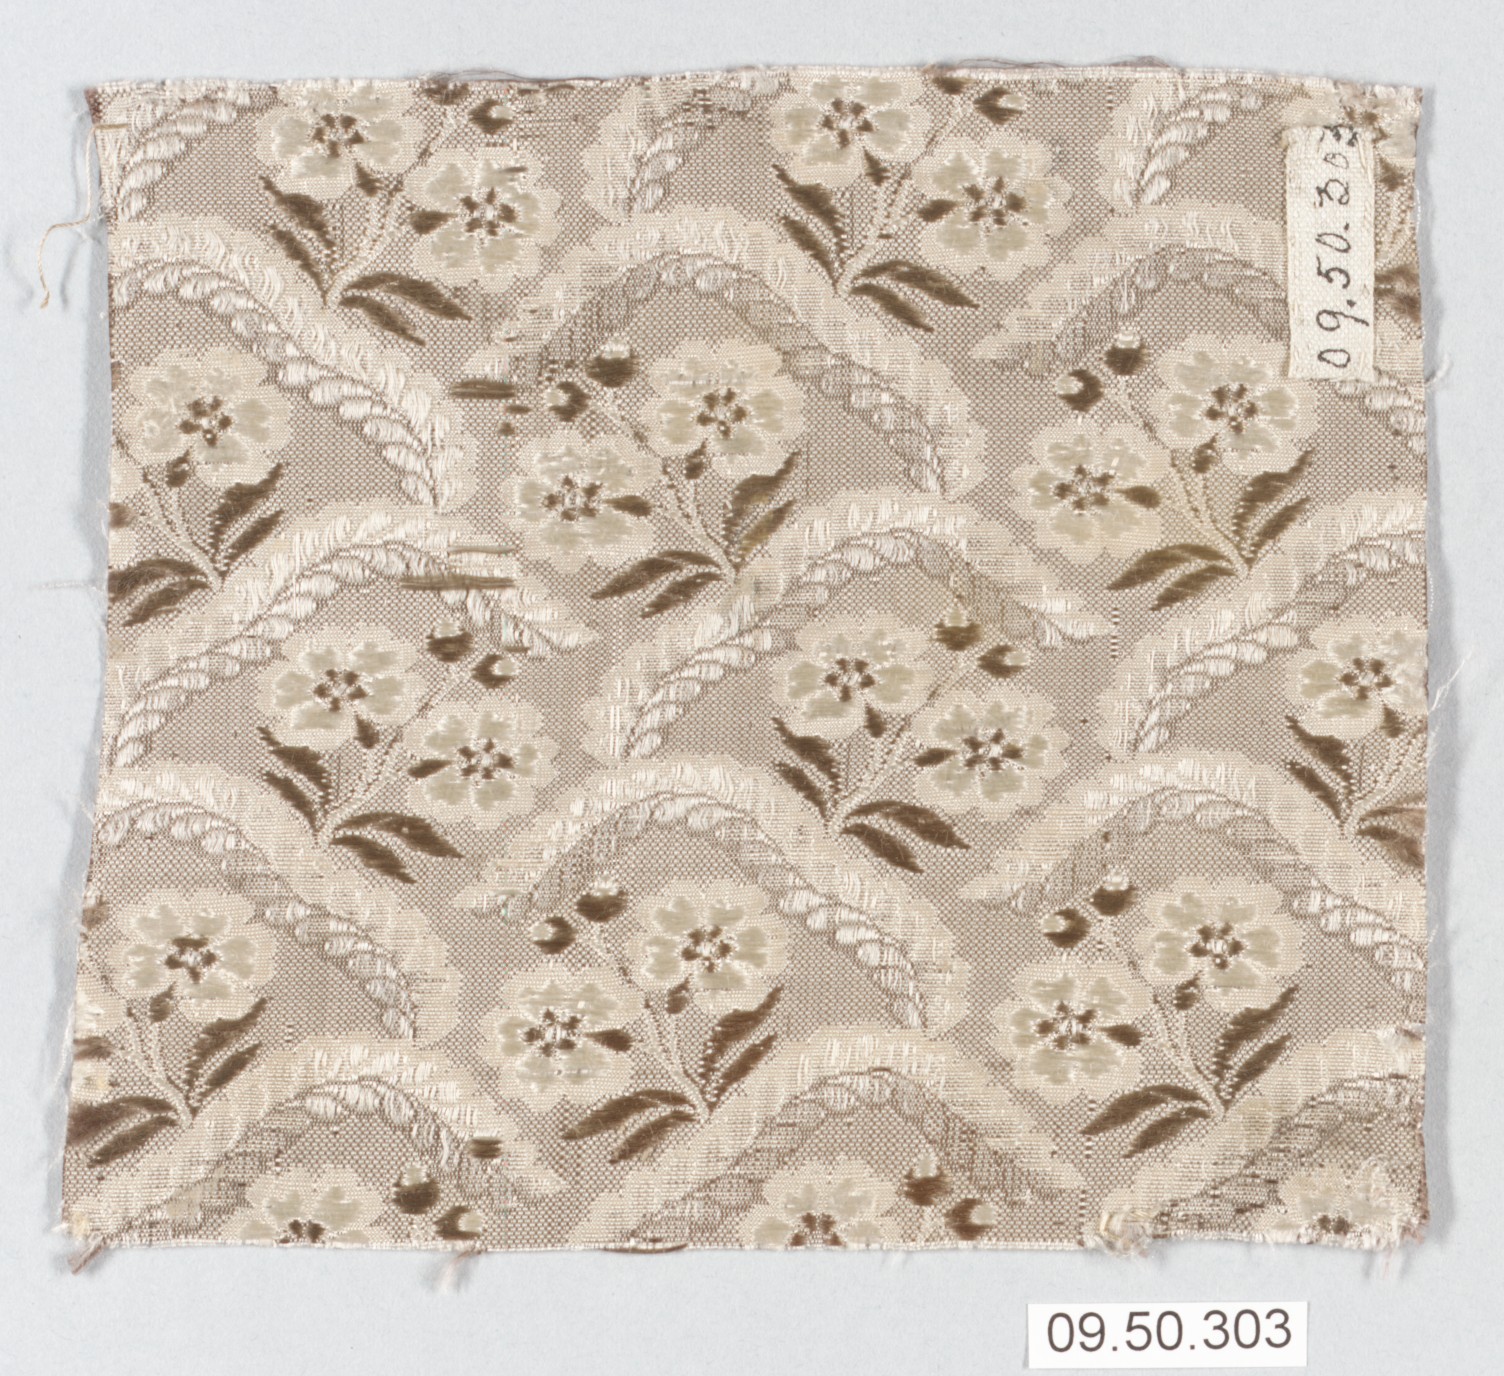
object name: piece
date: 1701-1800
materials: silk